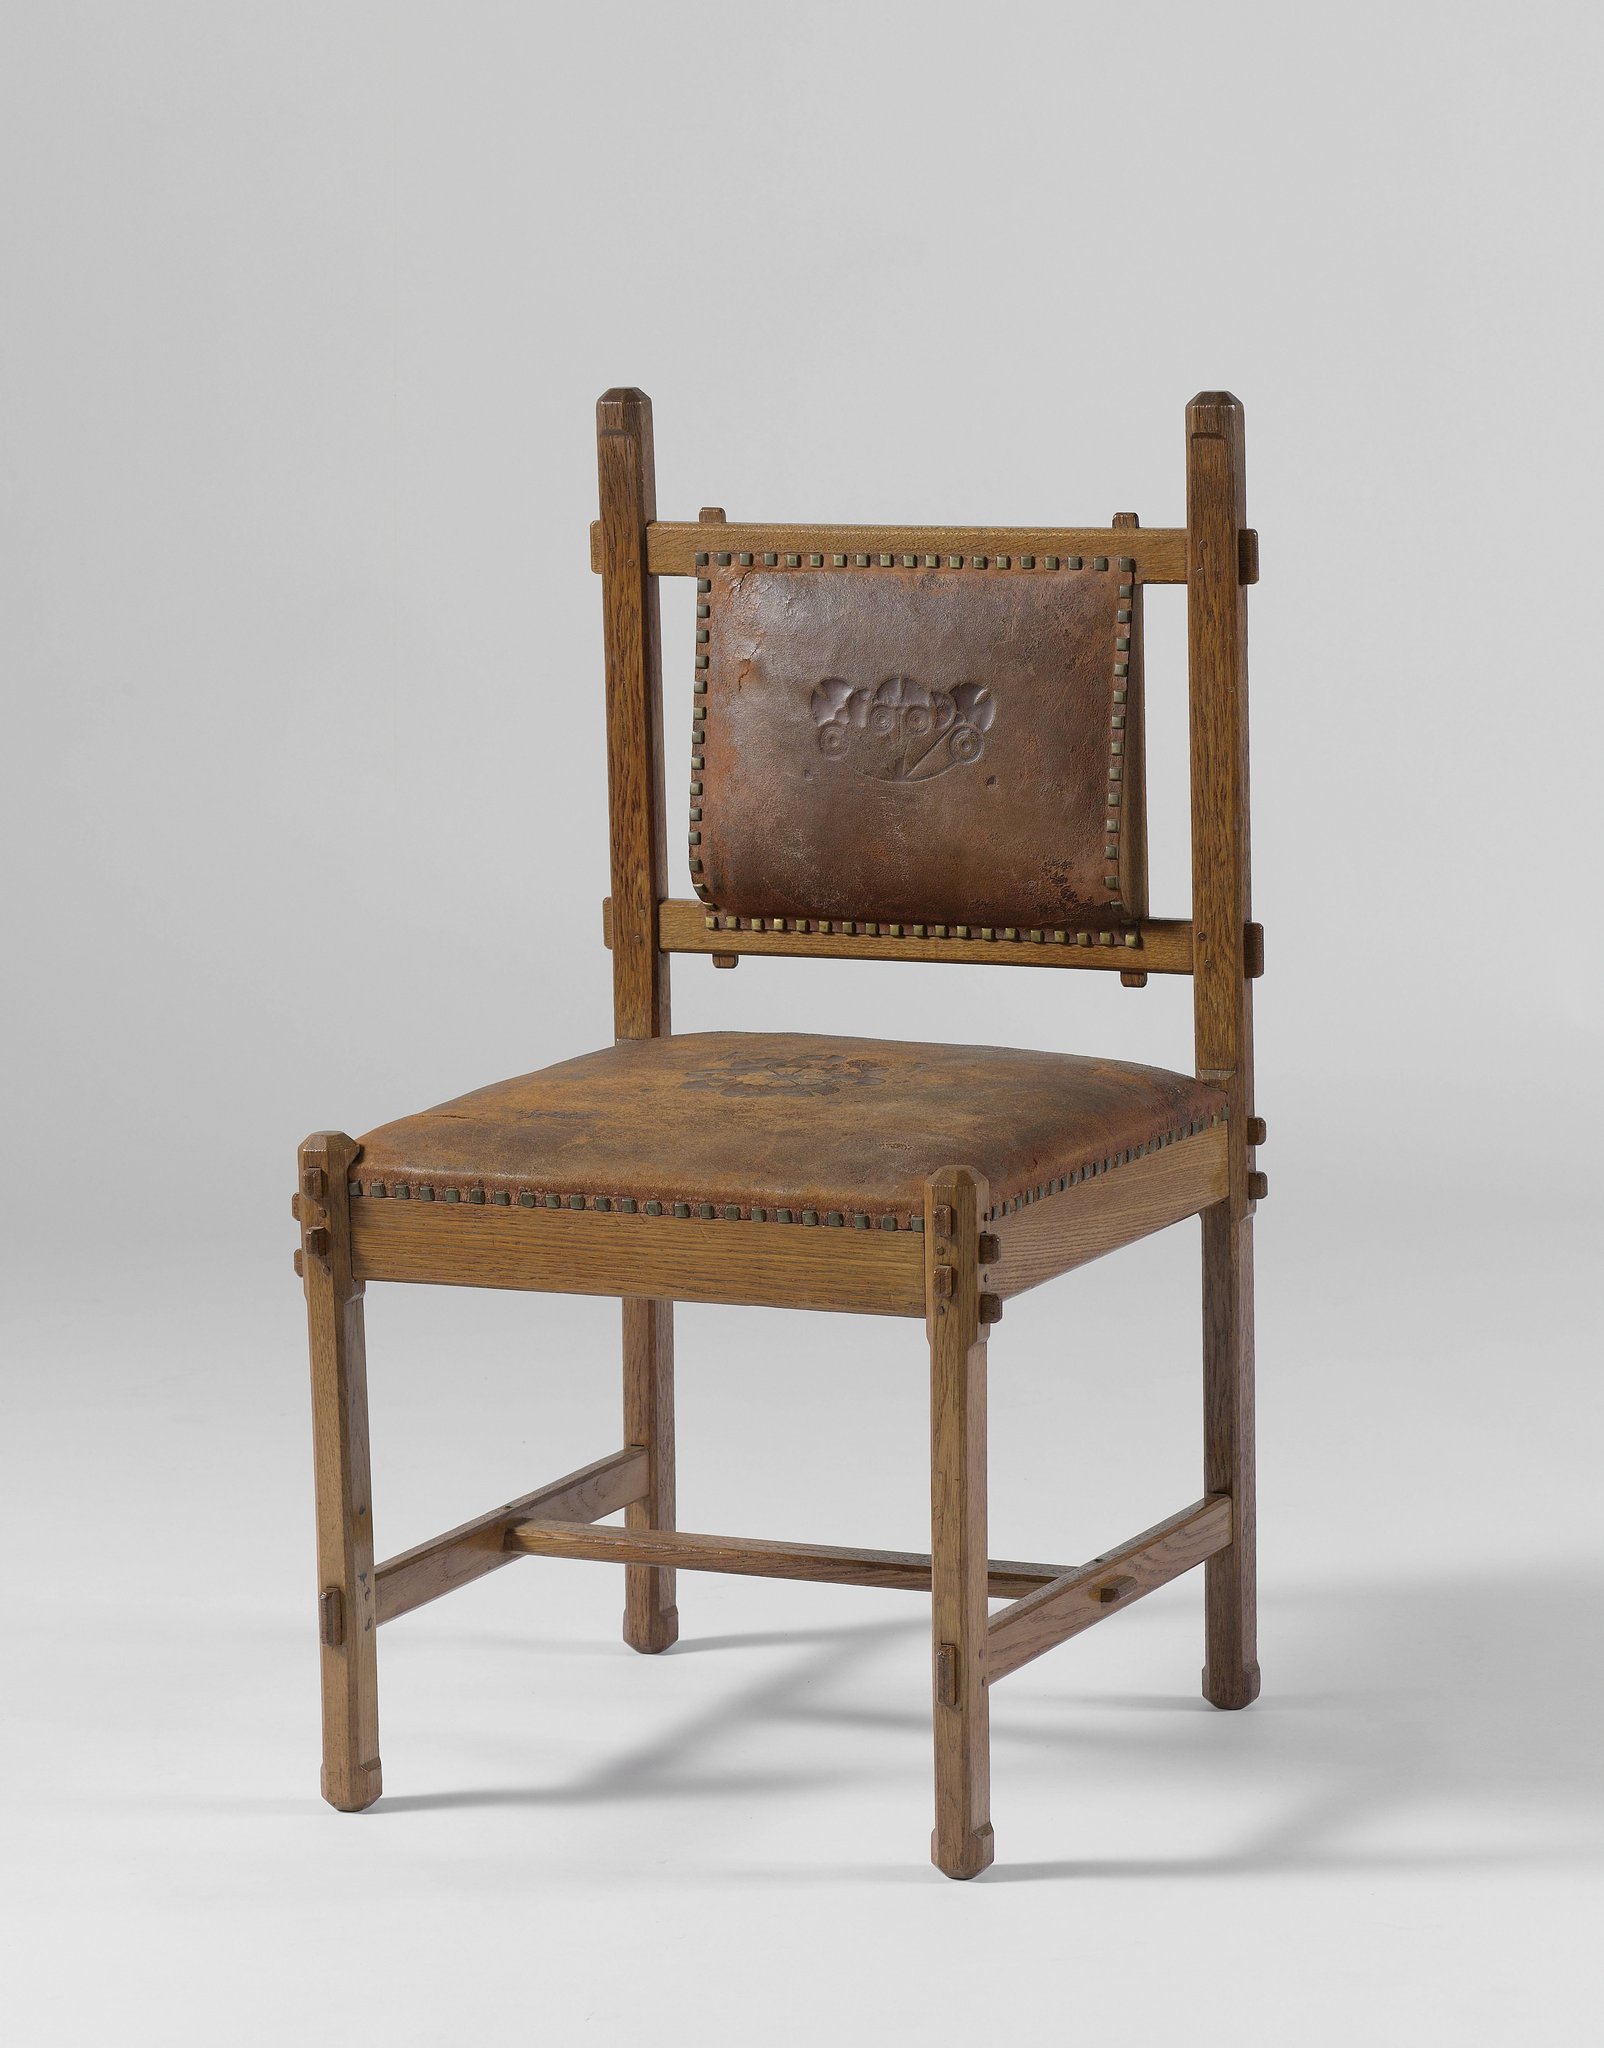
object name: furniture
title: Stoel van eikenhout, bekleed met bruin leer met in het midden van de zitting een bloem en op rug een tak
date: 1907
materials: leather, wood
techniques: printing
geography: amsterdam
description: Stoel, deel van een paar, van eikenhout met rechte poten met afgeschuinde hoeken, een vierkante zitting bekleed met bruin leer met in het midden een gestempelde gestileerde bloem, in de rug een bruin leren paneel met een gestempelde gestileerde tak. Amsterdam, Gebroeders Vogel, 1907, naar ontwerp van A.J. Kropholler met medewerking van M. Kropholler en J.F. Staal, de leren bekleding naar ontwerp van S. Jessurum de Mesquita. Vervaardigd voor de heer Romijn.